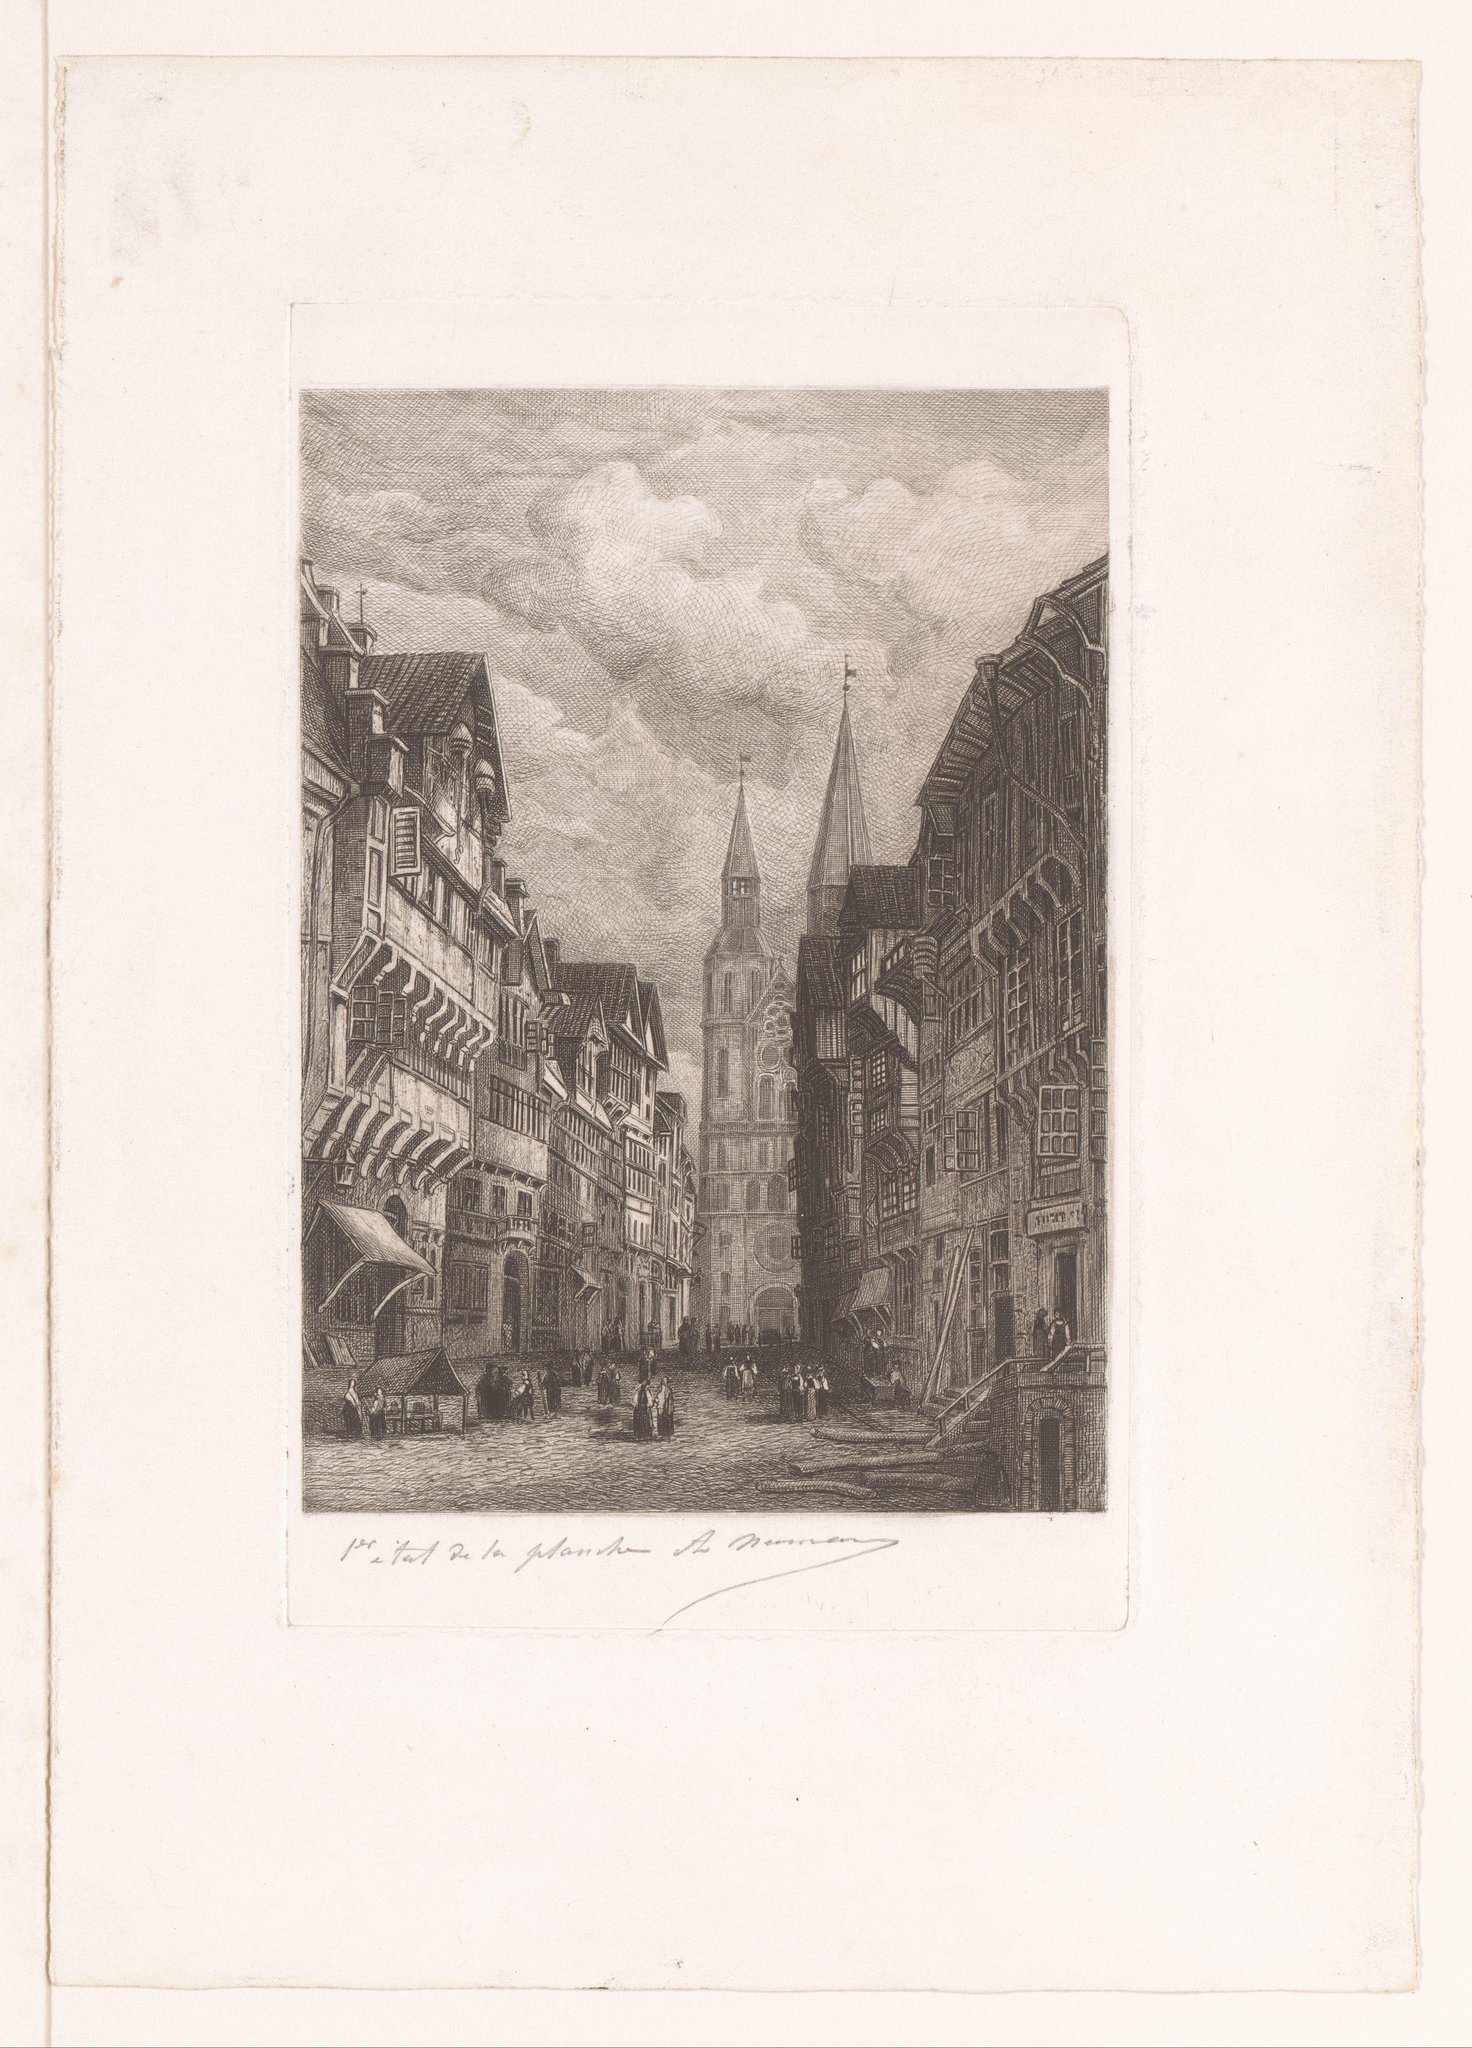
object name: print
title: Gezicht op een straat in Braunschweig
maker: auguste numans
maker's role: print maker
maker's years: 1823-1883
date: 1833-1879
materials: paper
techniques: etching, intaglio, roulette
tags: church (exterior), street (+ city(-scape) with figures, staffage)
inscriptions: collector's mark: Lugt 2228, inscription: ‘1er etat de la planche A Numans’